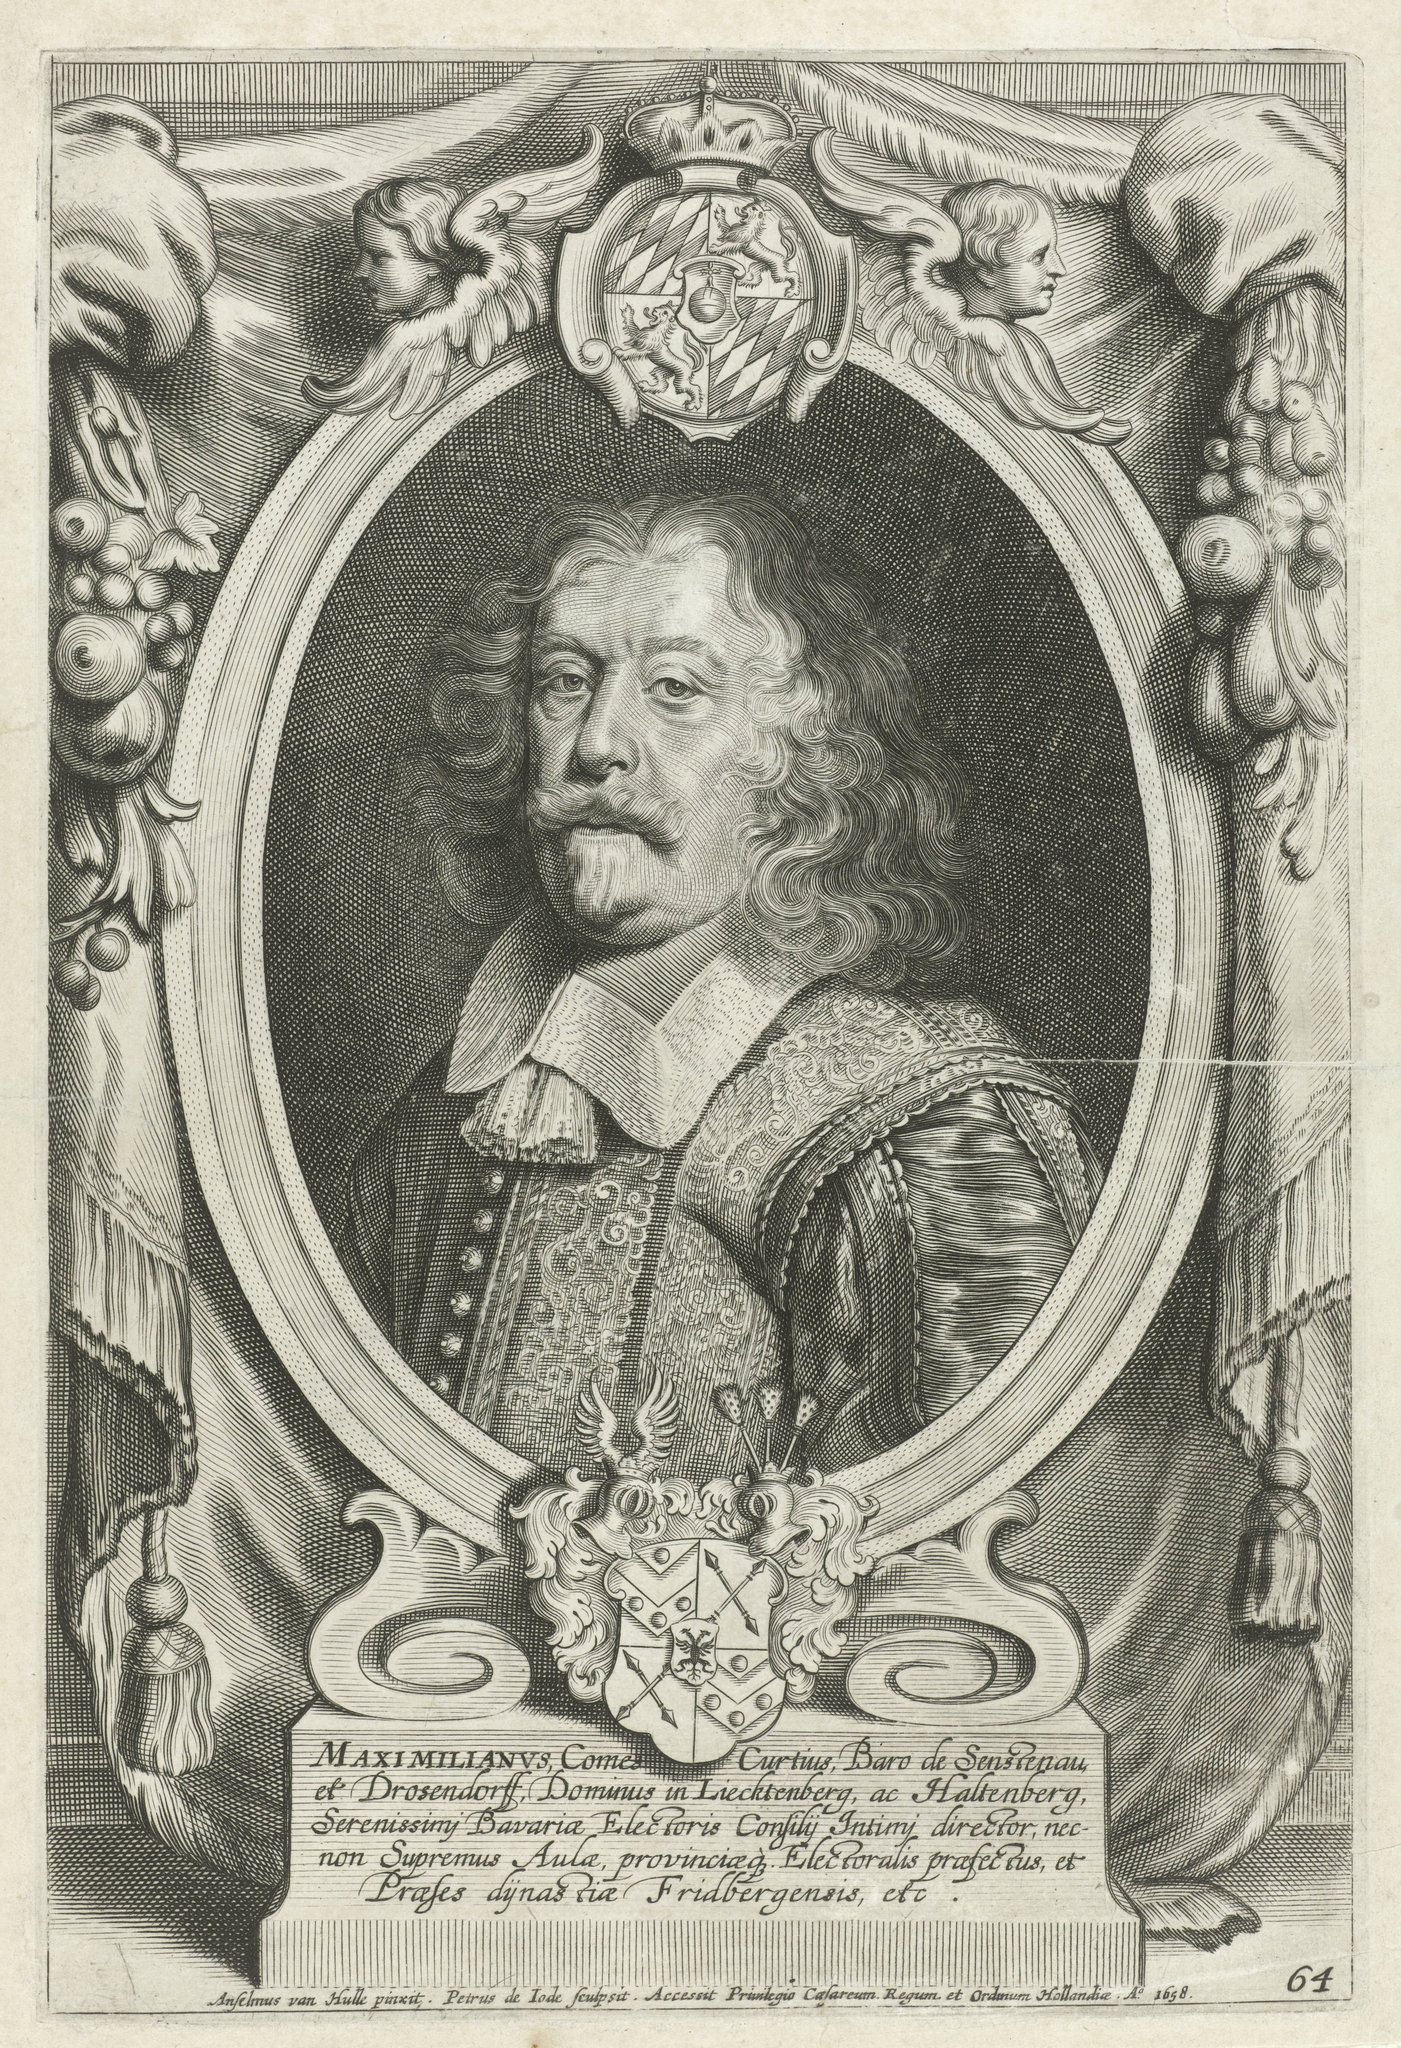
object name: print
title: Portret van Maximilian Kurtz von Senftenau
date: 1658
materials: paper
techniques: engraving, etching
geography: antwerp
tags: politician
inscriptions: collector's mark: Lugt 2228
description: Busteportret van Maximilian Kurtz von Senftenau. Rechtsonder: 64. Het portret is gevat in een ovale omlijsting met het wapenschild van de geportretteerde en decoraties. In het kader een vijfregelig onderschrift in het Latijn. Prent uit een serie portretten naar schilderijen van Anselmus van Hulle van alle gedelegeerden bij de vredesonderhandelingen te Münster en Osnabrück.